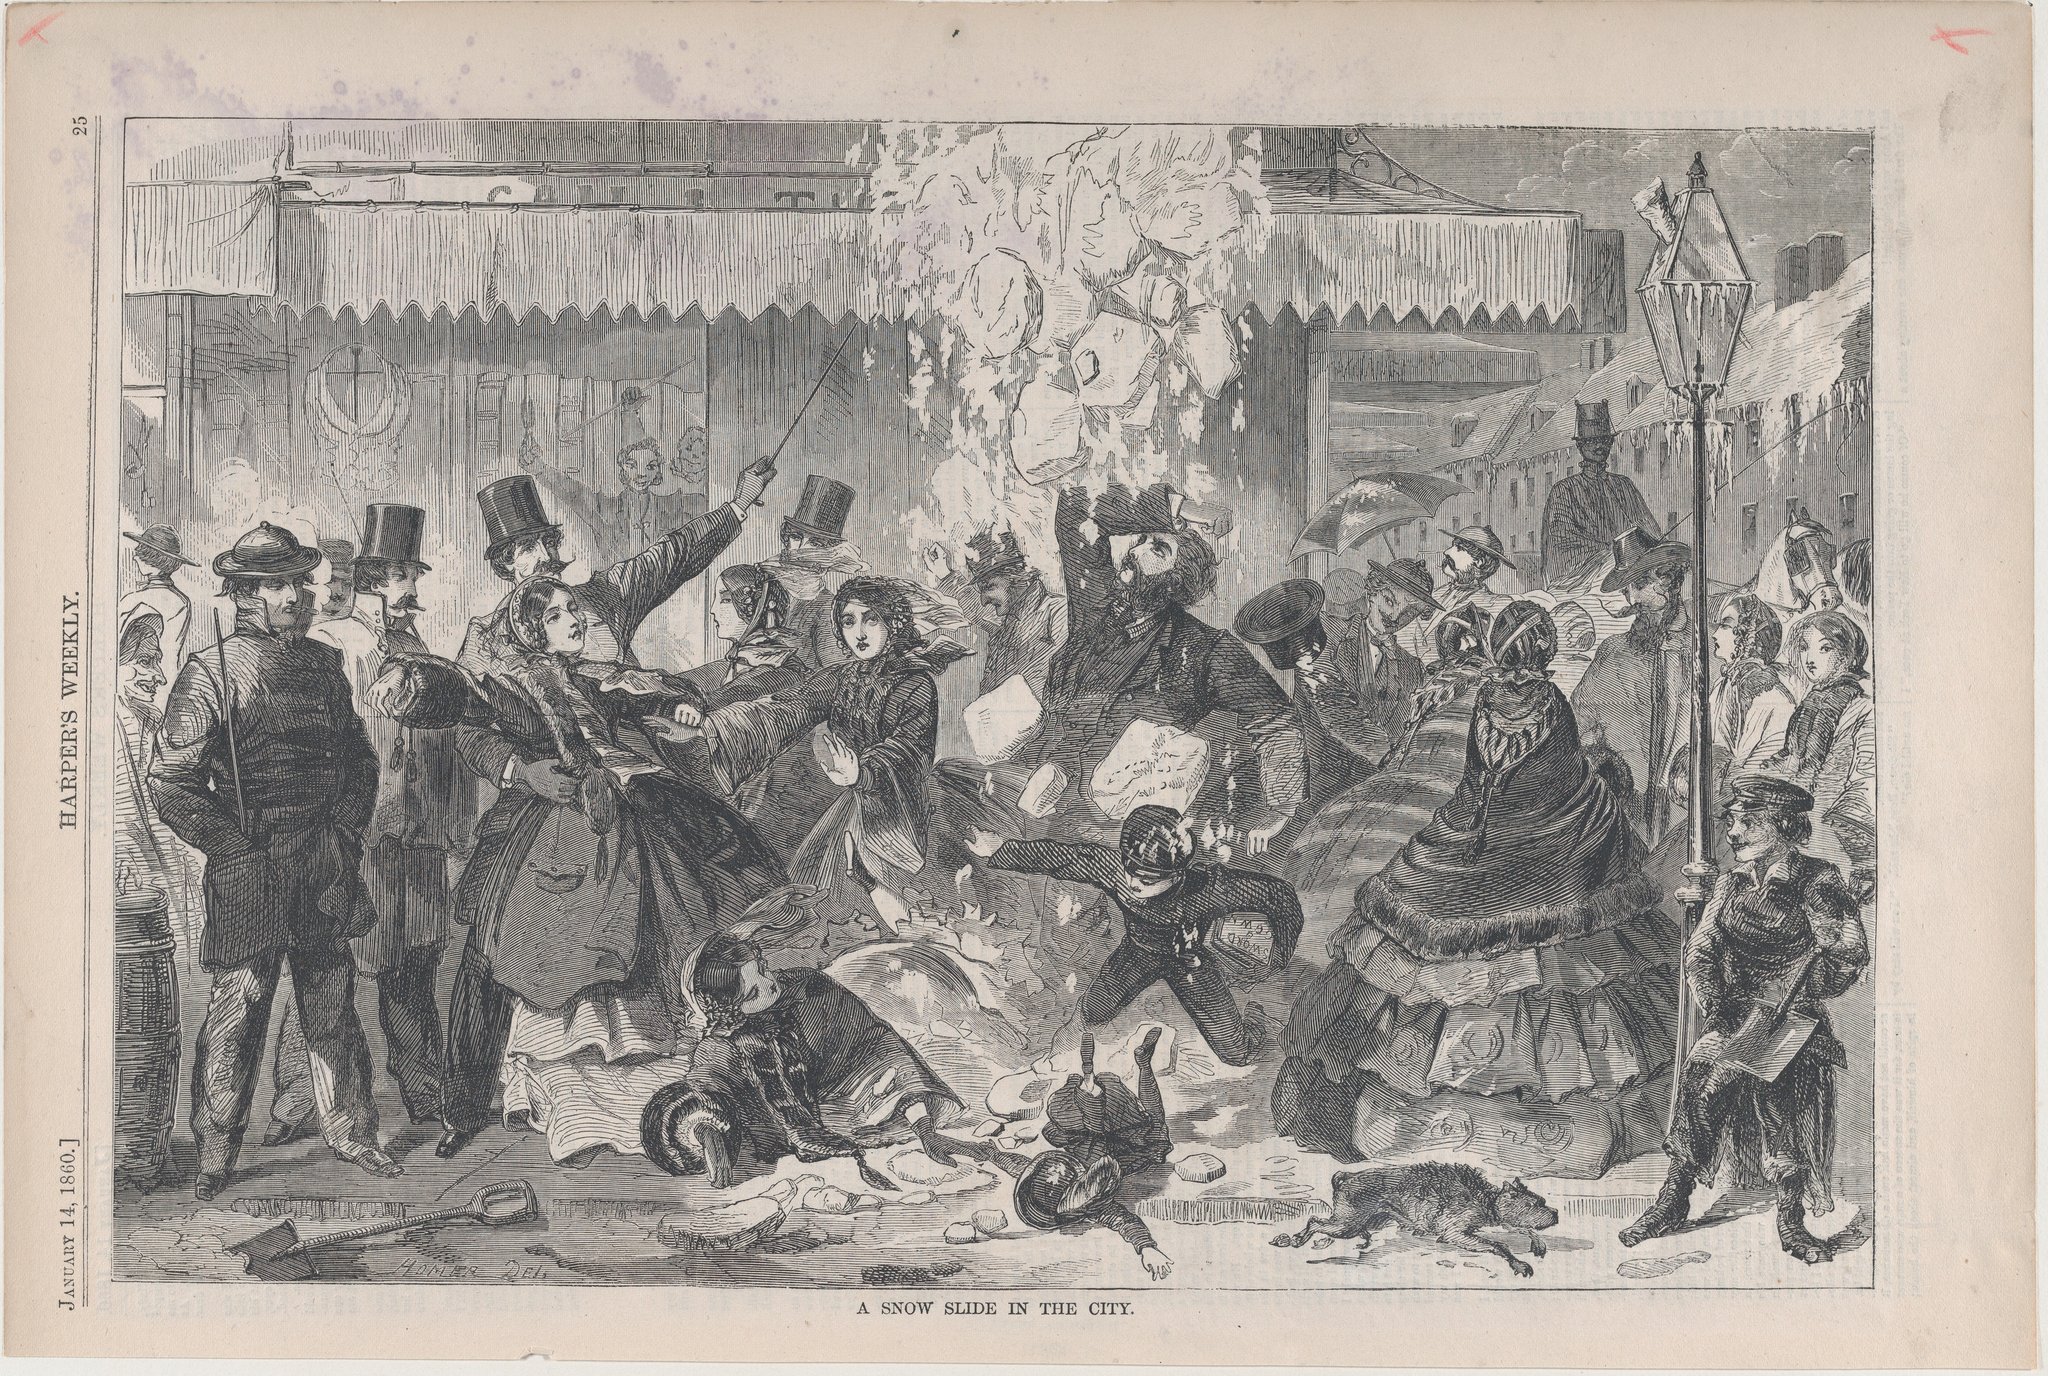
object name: print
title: A Snow Slide in the City (from "Harper's Weekly," Vol. IV)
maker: winslow homer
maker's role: artist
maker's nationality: american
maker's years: 1836-1910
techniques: engraving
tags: animals,men,women,snow